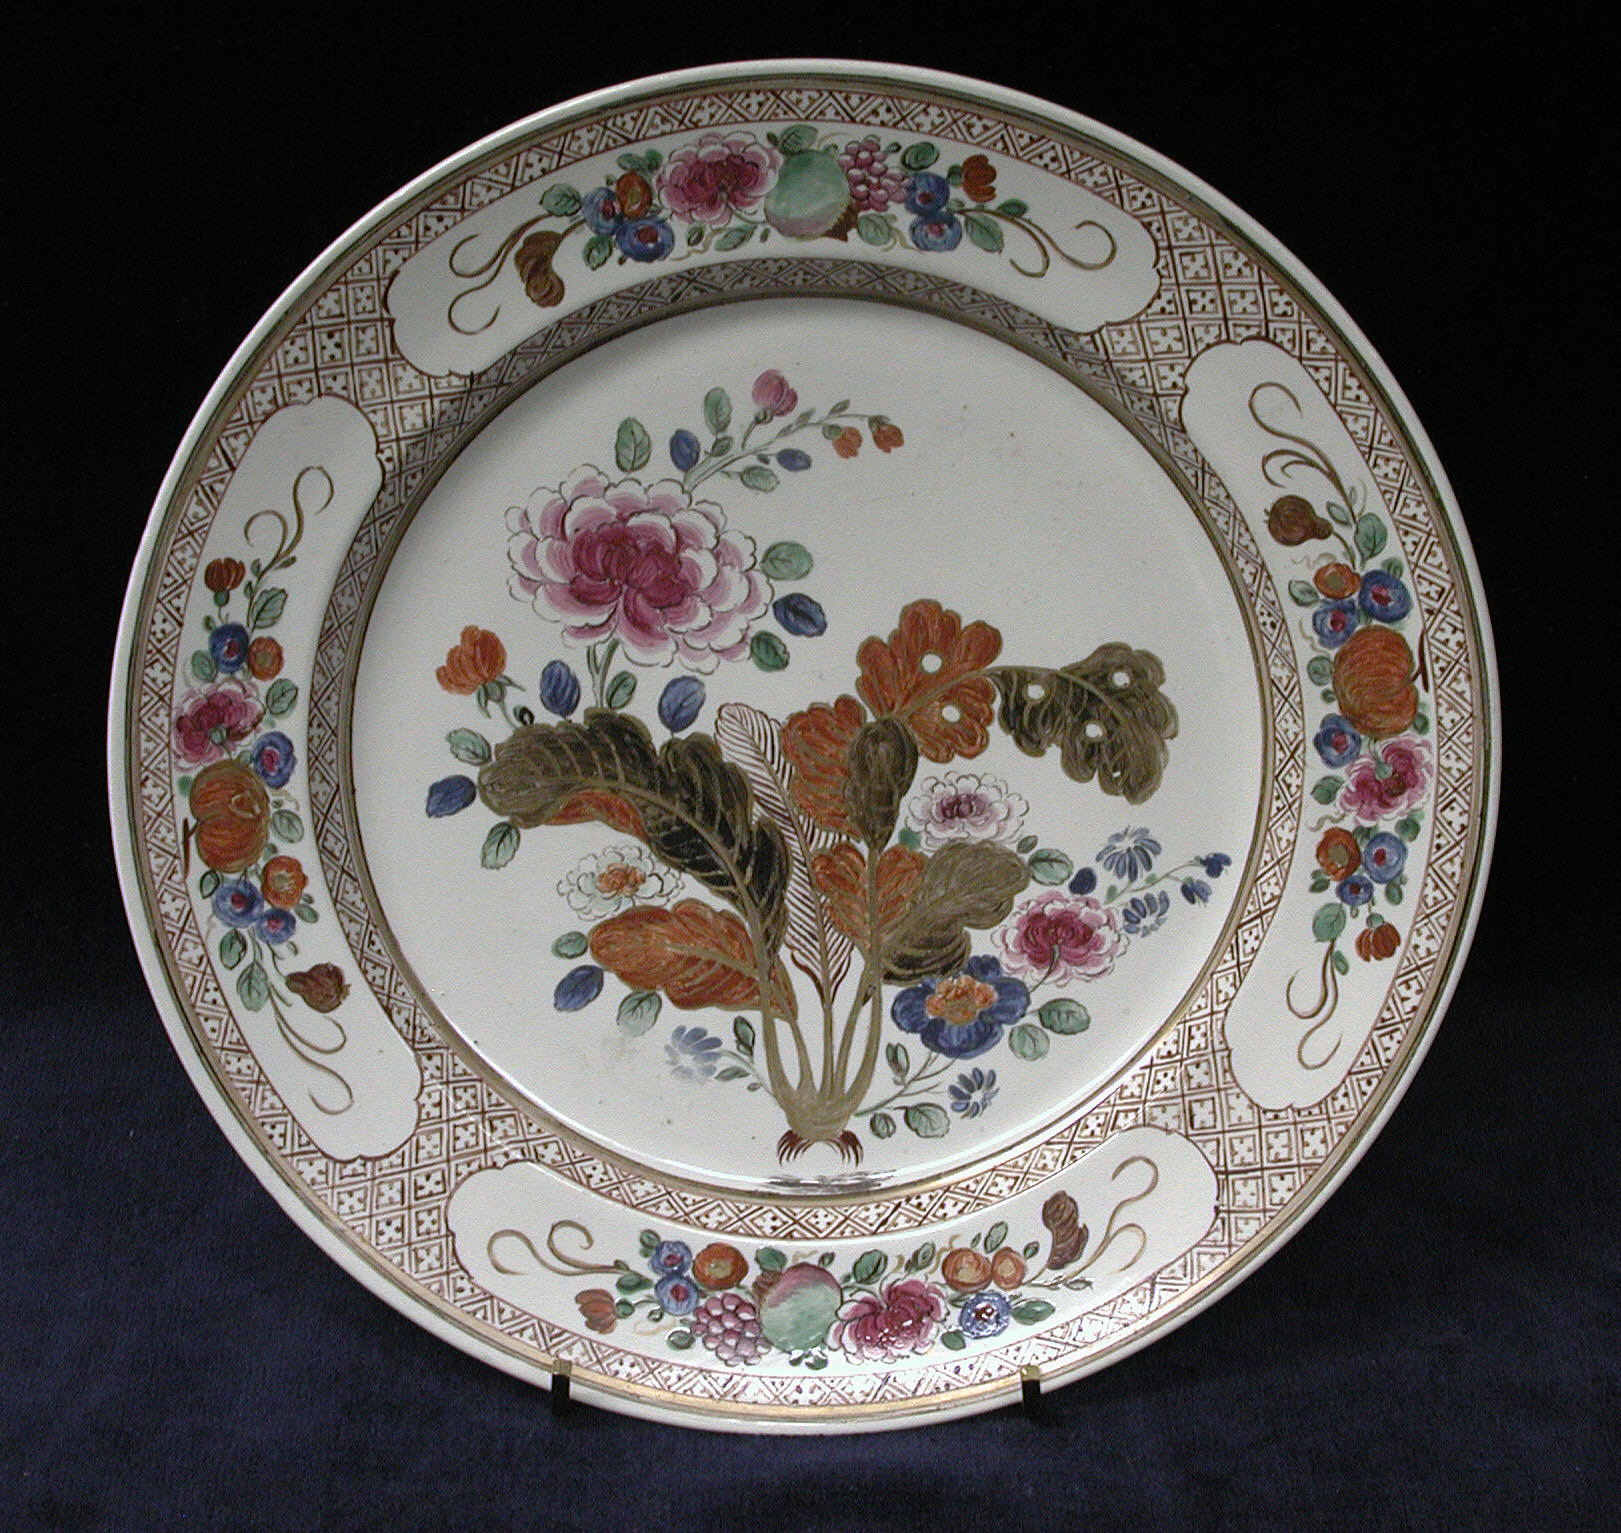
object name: plate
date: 1770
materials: earthenware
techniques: glazing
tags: flowers